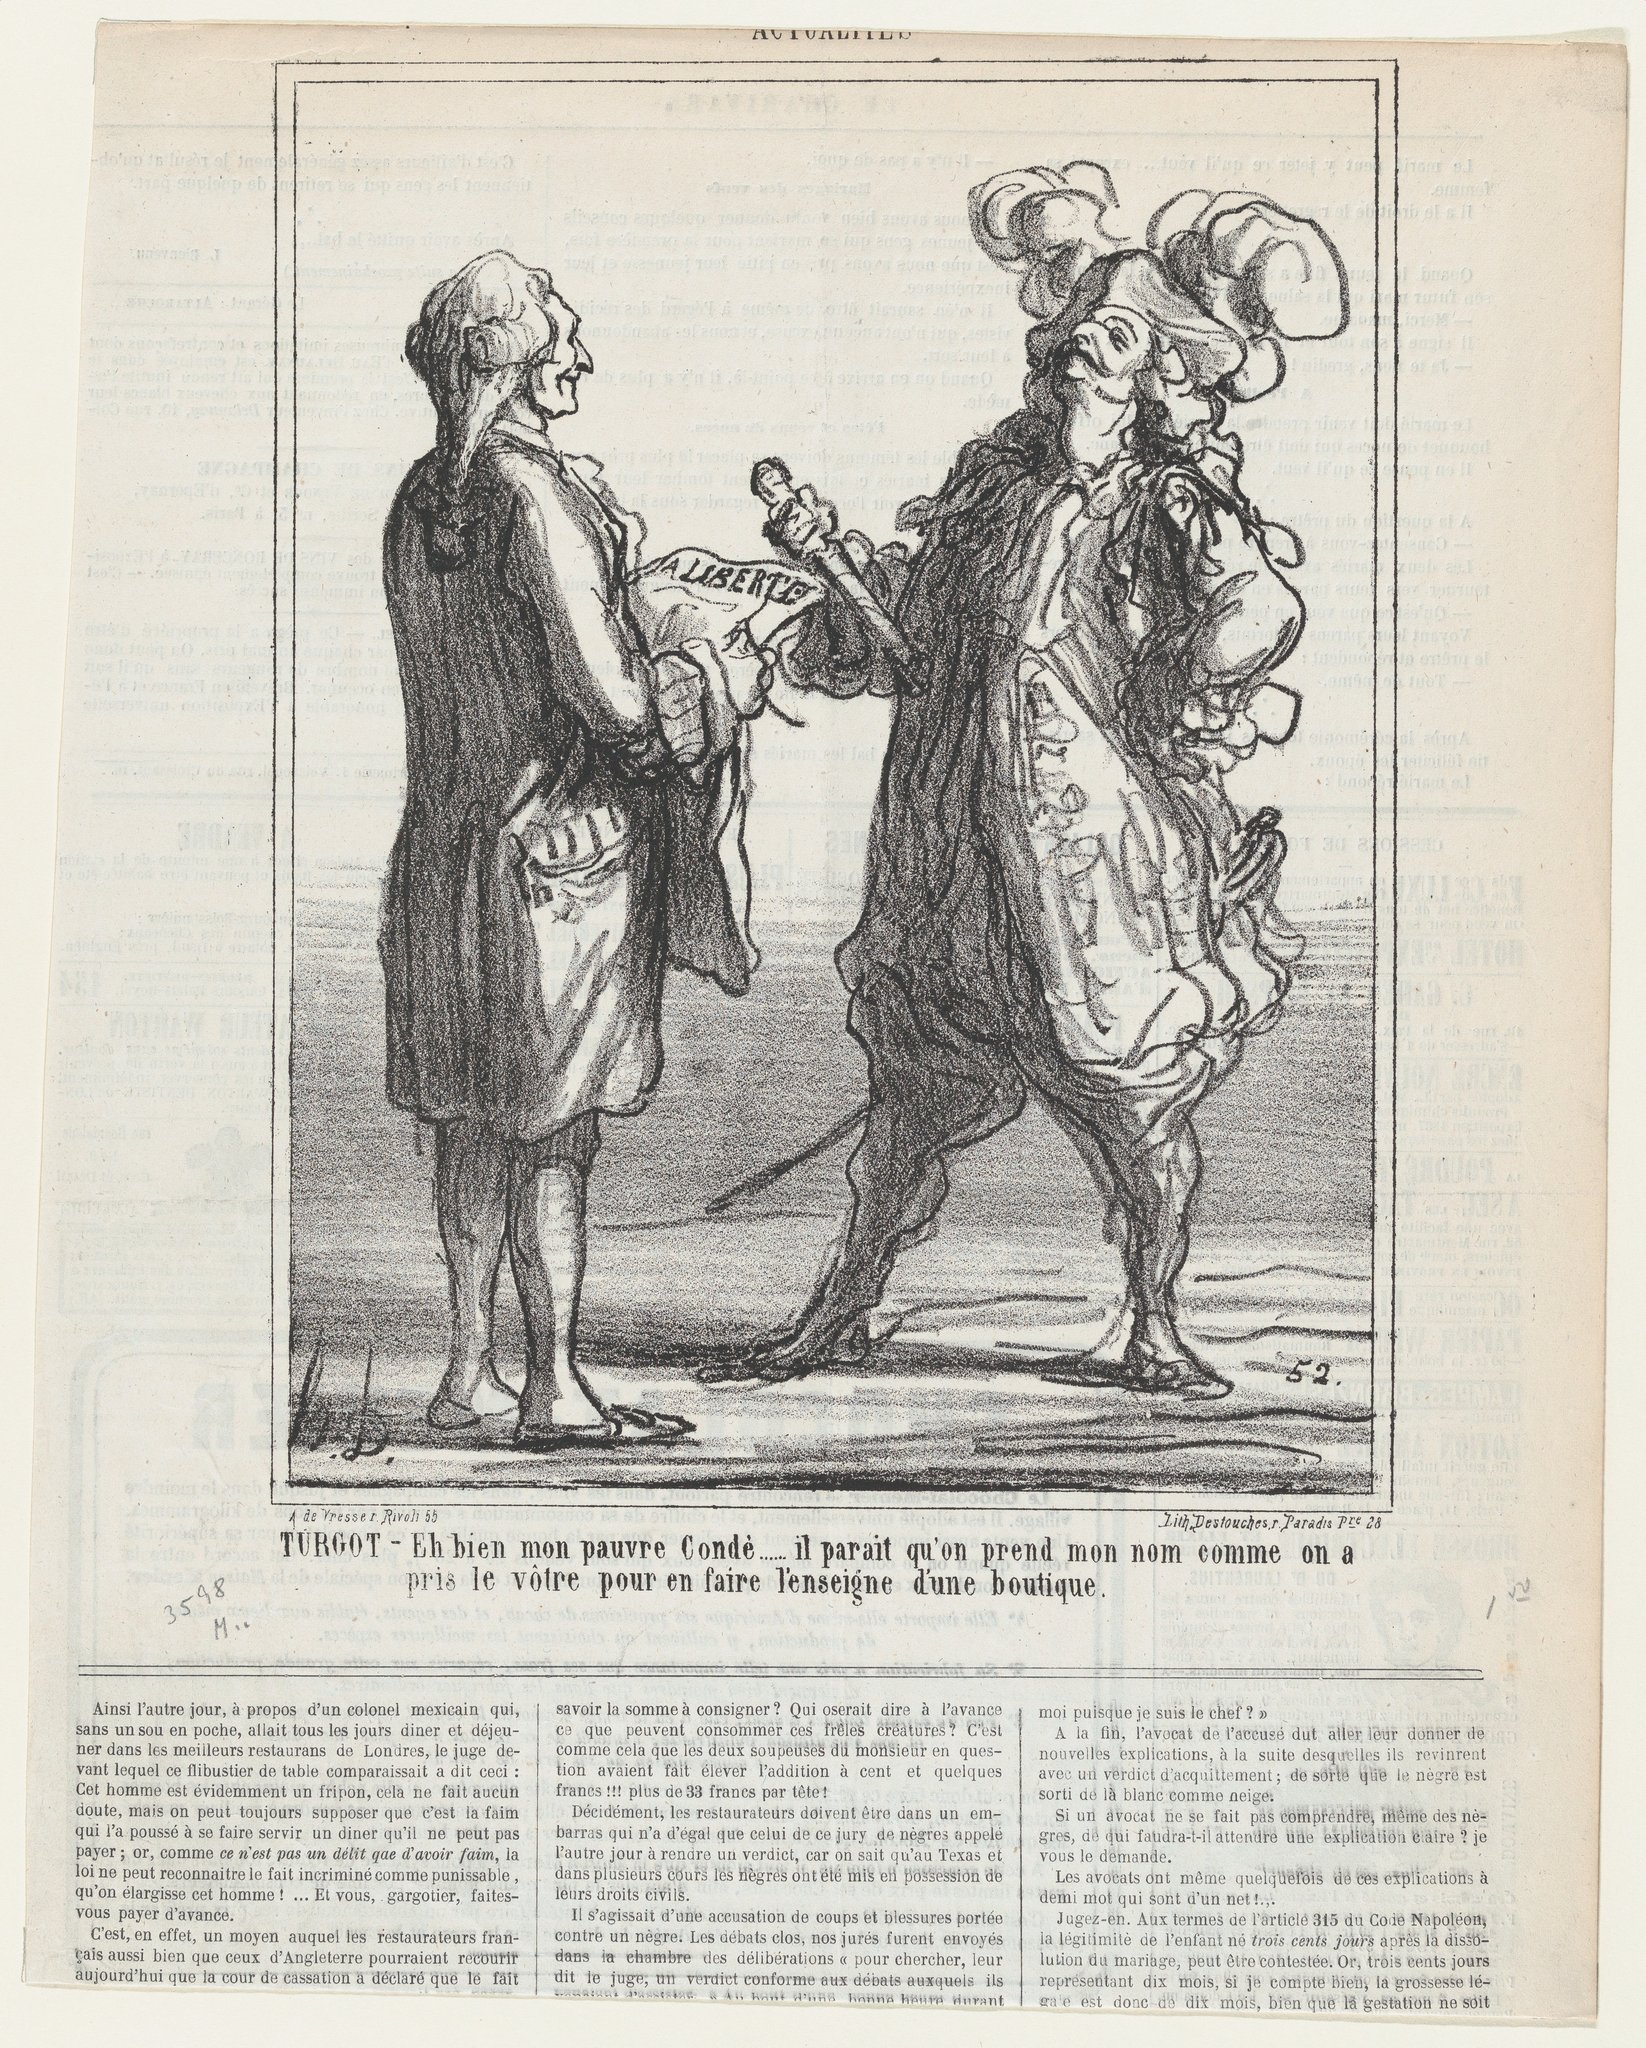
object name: print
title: Turgot: –Eh, well, my poor Count, it appears that they borrow my name as they have taken yours for the sake of creating the sign of a shop, from 'News of the day,' published in Le Charivari, October 7, 1867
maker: honoré daumier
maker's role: artist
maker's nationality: french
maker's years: 1808-1879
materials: paper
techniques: lithograph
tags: men